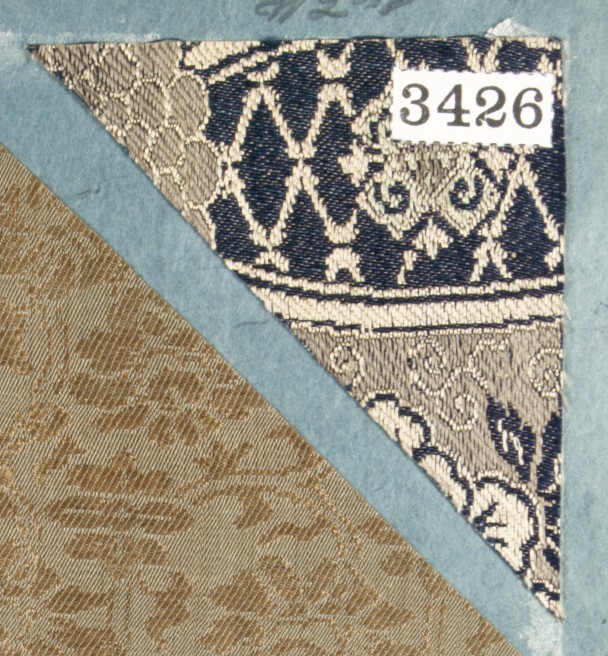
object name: textile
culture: japanese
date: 1801-1900